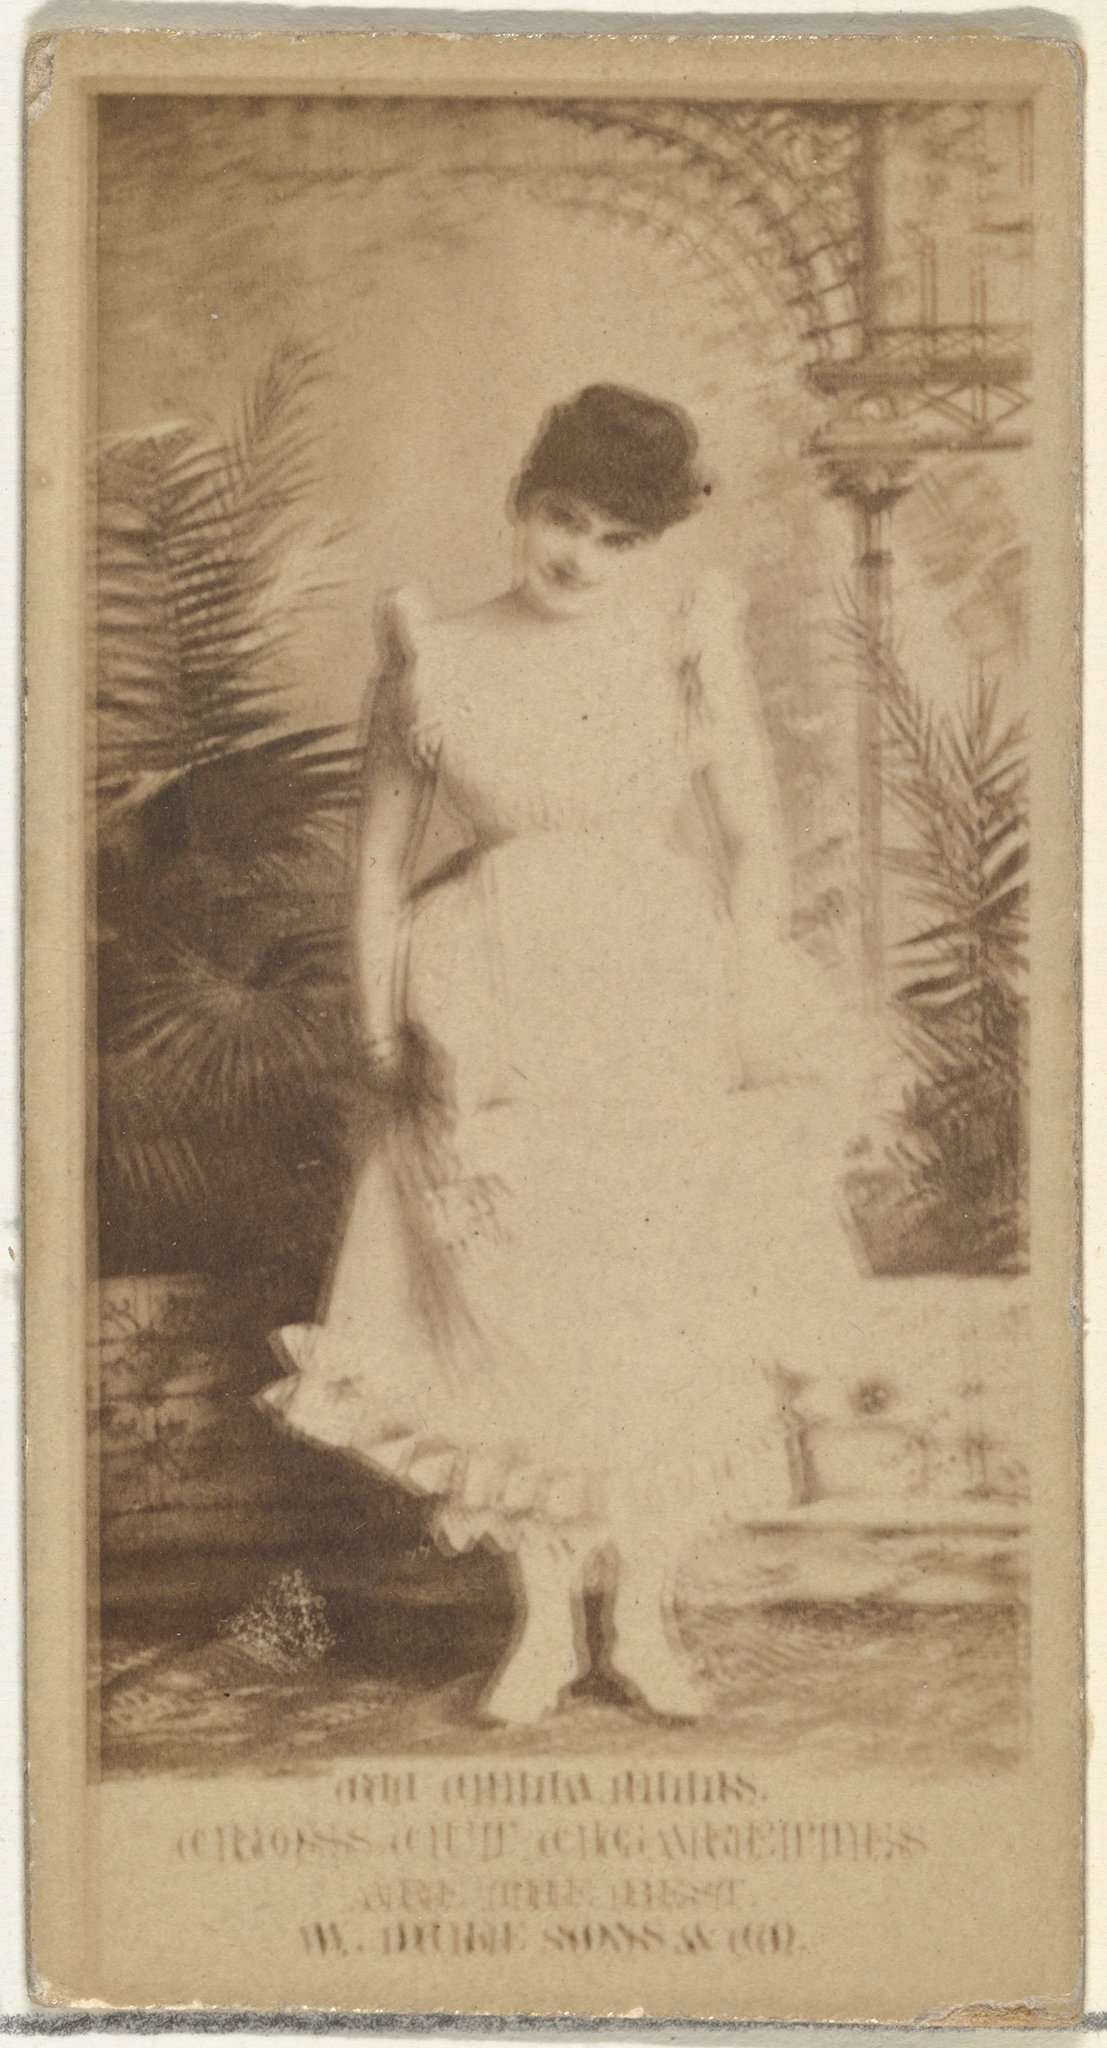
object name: photograph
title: Celia Ellis, from the Actors and Actresses series (N145-3) issued by Duke Sons & Co. to promote Cross Cut Cigarettes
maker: w. duke, sons & co.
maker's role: publisher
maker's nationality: american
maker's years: 1870-1920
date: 1880-1889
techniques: albumen silver print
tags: portraits,women,actresses